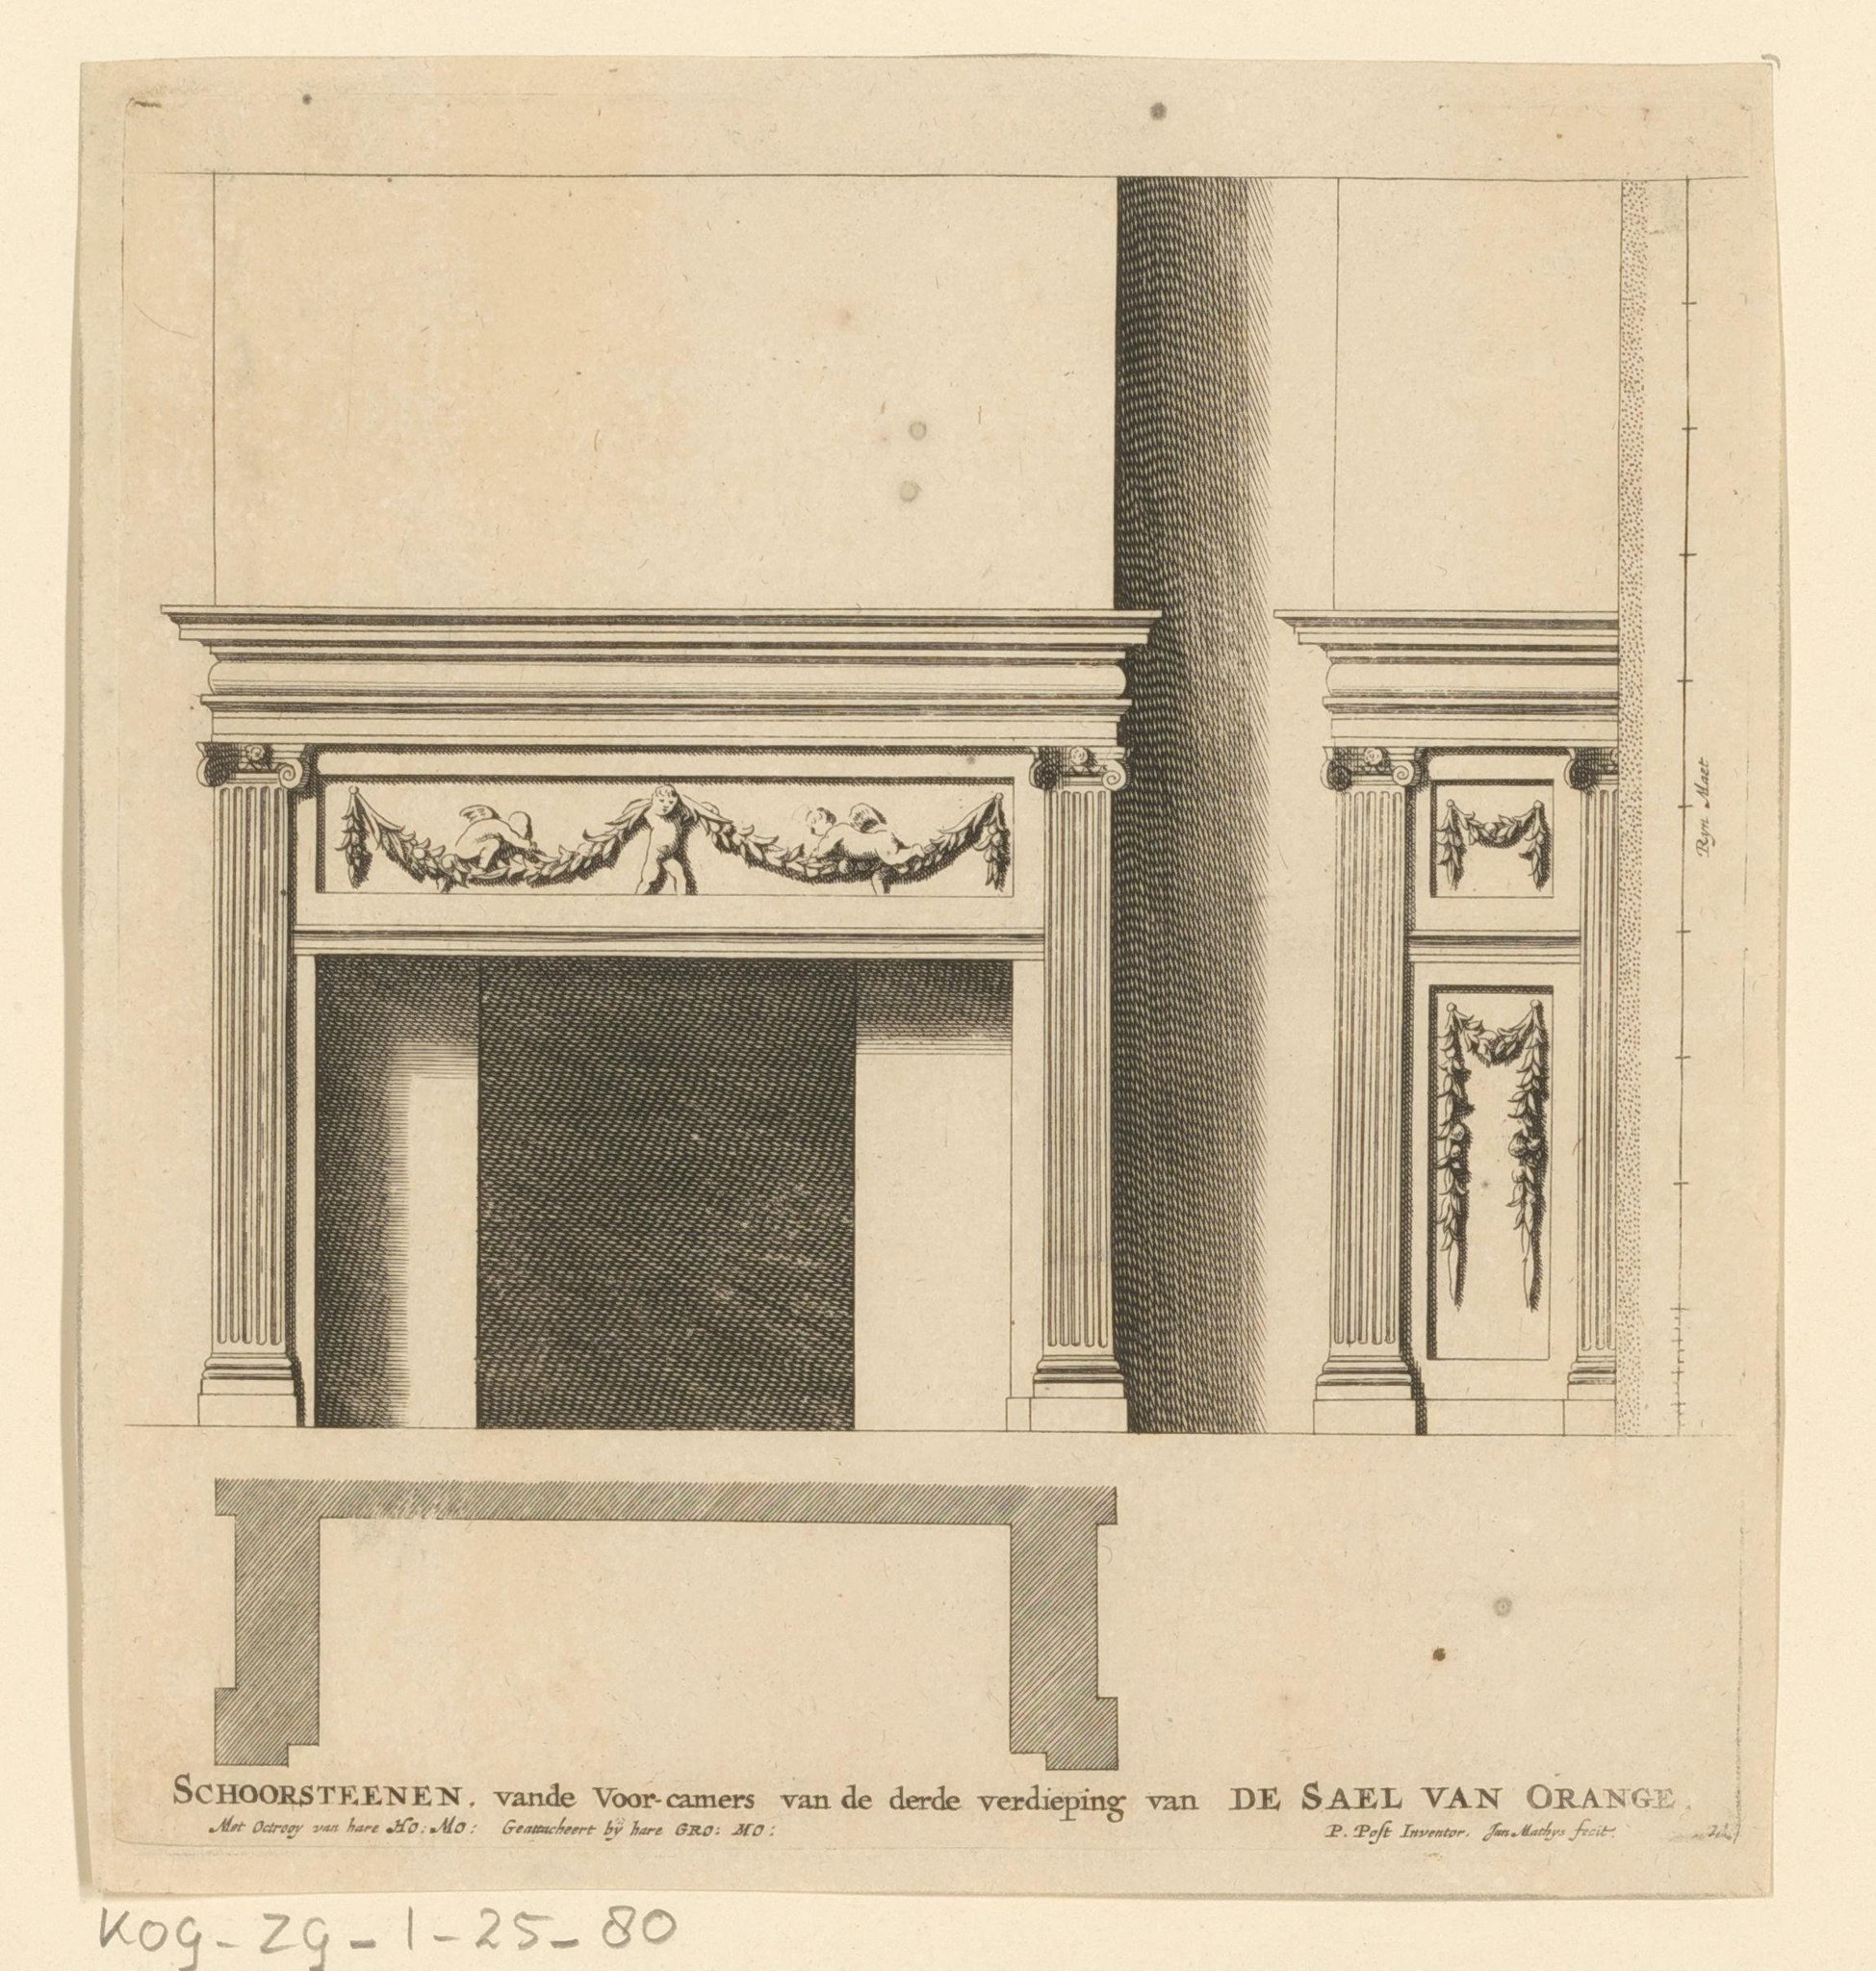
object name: ornament print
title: Schoorsteenen, vande Voor-camers van de derde verdieping van de Sael van Orange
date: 1669-1706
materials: paper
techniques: engraving, etching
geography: amsterdam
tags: chimney, chimney ornaments, chimney-piece, mantelpiece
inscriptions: stamp:, stamp:, collector's mark: Lugt 1641, collector's mark: Lugt 1641a, stamp:, : ‘Met Octrooy van hare HO: MO: Geattacheert bij hare GRO: MO:’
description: Titelprent is onderdeel van een serie bestaande uit een titelprent en 22 vervolg prenten. De serie is voor het eerst uitgegeven door Pieter Jansz. Post in Den Haag of Rotterdam. De huidige (tweede staat) is uitgegeven door Frederik de Wit tussen 1669 en 1706. De volgorde van de prenten is in deze serie veranderd. De prenten zijn een derde keer uitgegeven door Pieter van der Aa in 1715 te Leiden. Hier is de volgorde wederom aangepast.